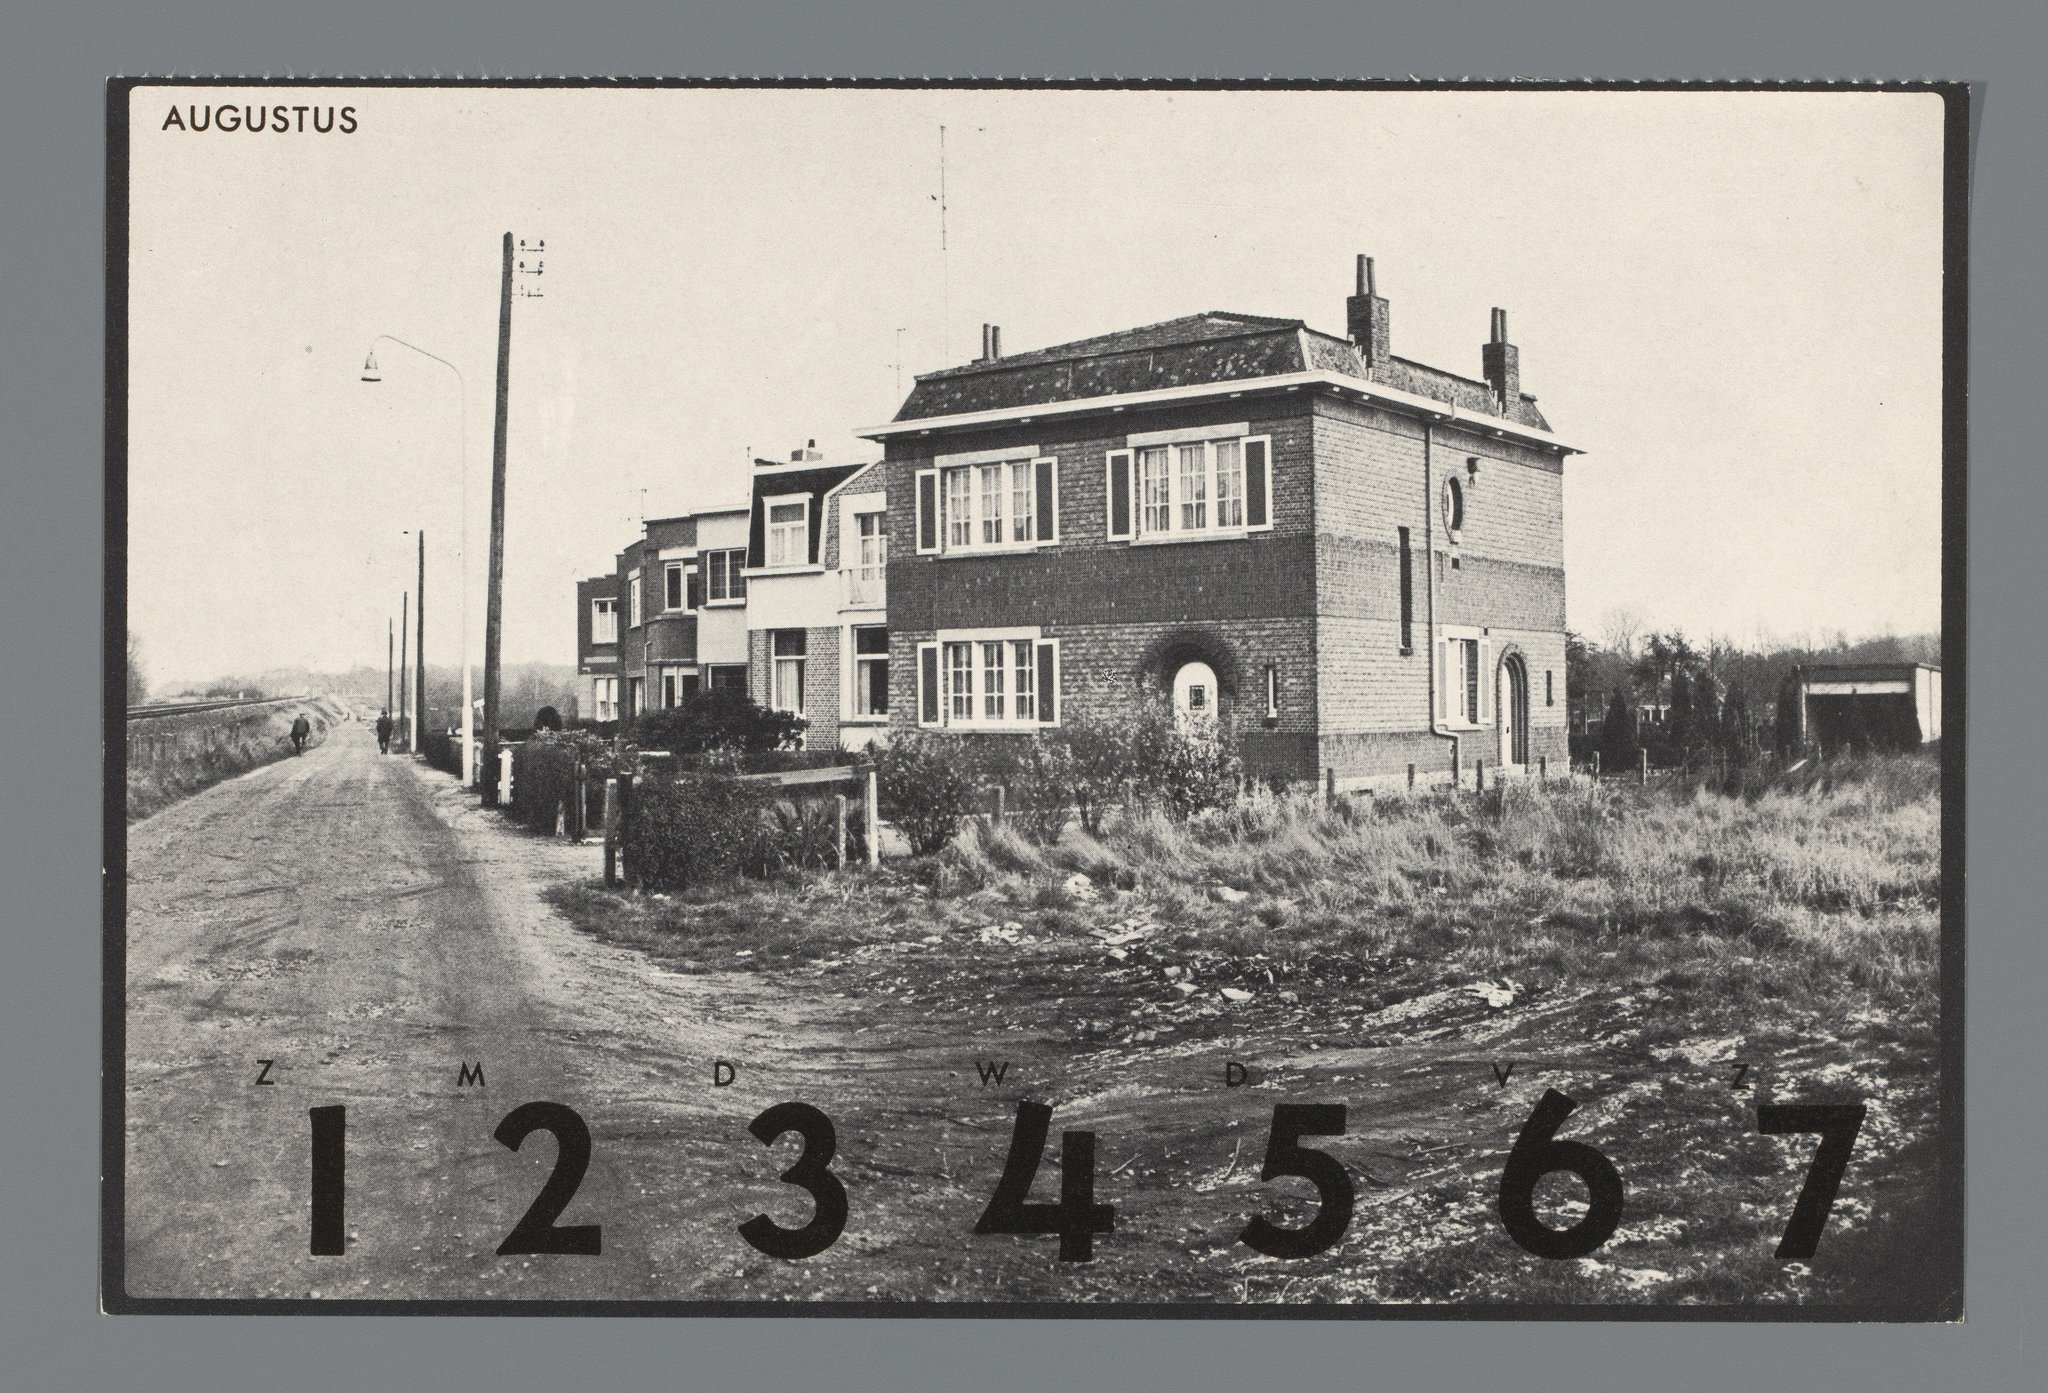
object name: photograph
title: België. Huizen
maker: Anonymous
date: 1900-1950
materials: paper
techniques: offset printed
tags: belgium